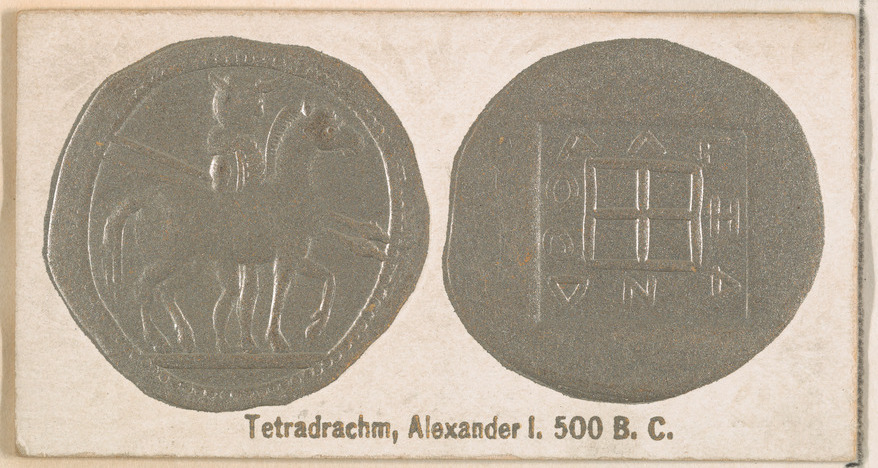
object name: print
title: Tetradrachm, Alexander I, 500 B.C., from the Ancient Coins series (N180) issued by Wm. S. Kimball & Co.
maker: william s. kimball & company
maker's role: publisher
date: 1888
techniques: color lithograph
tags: coins